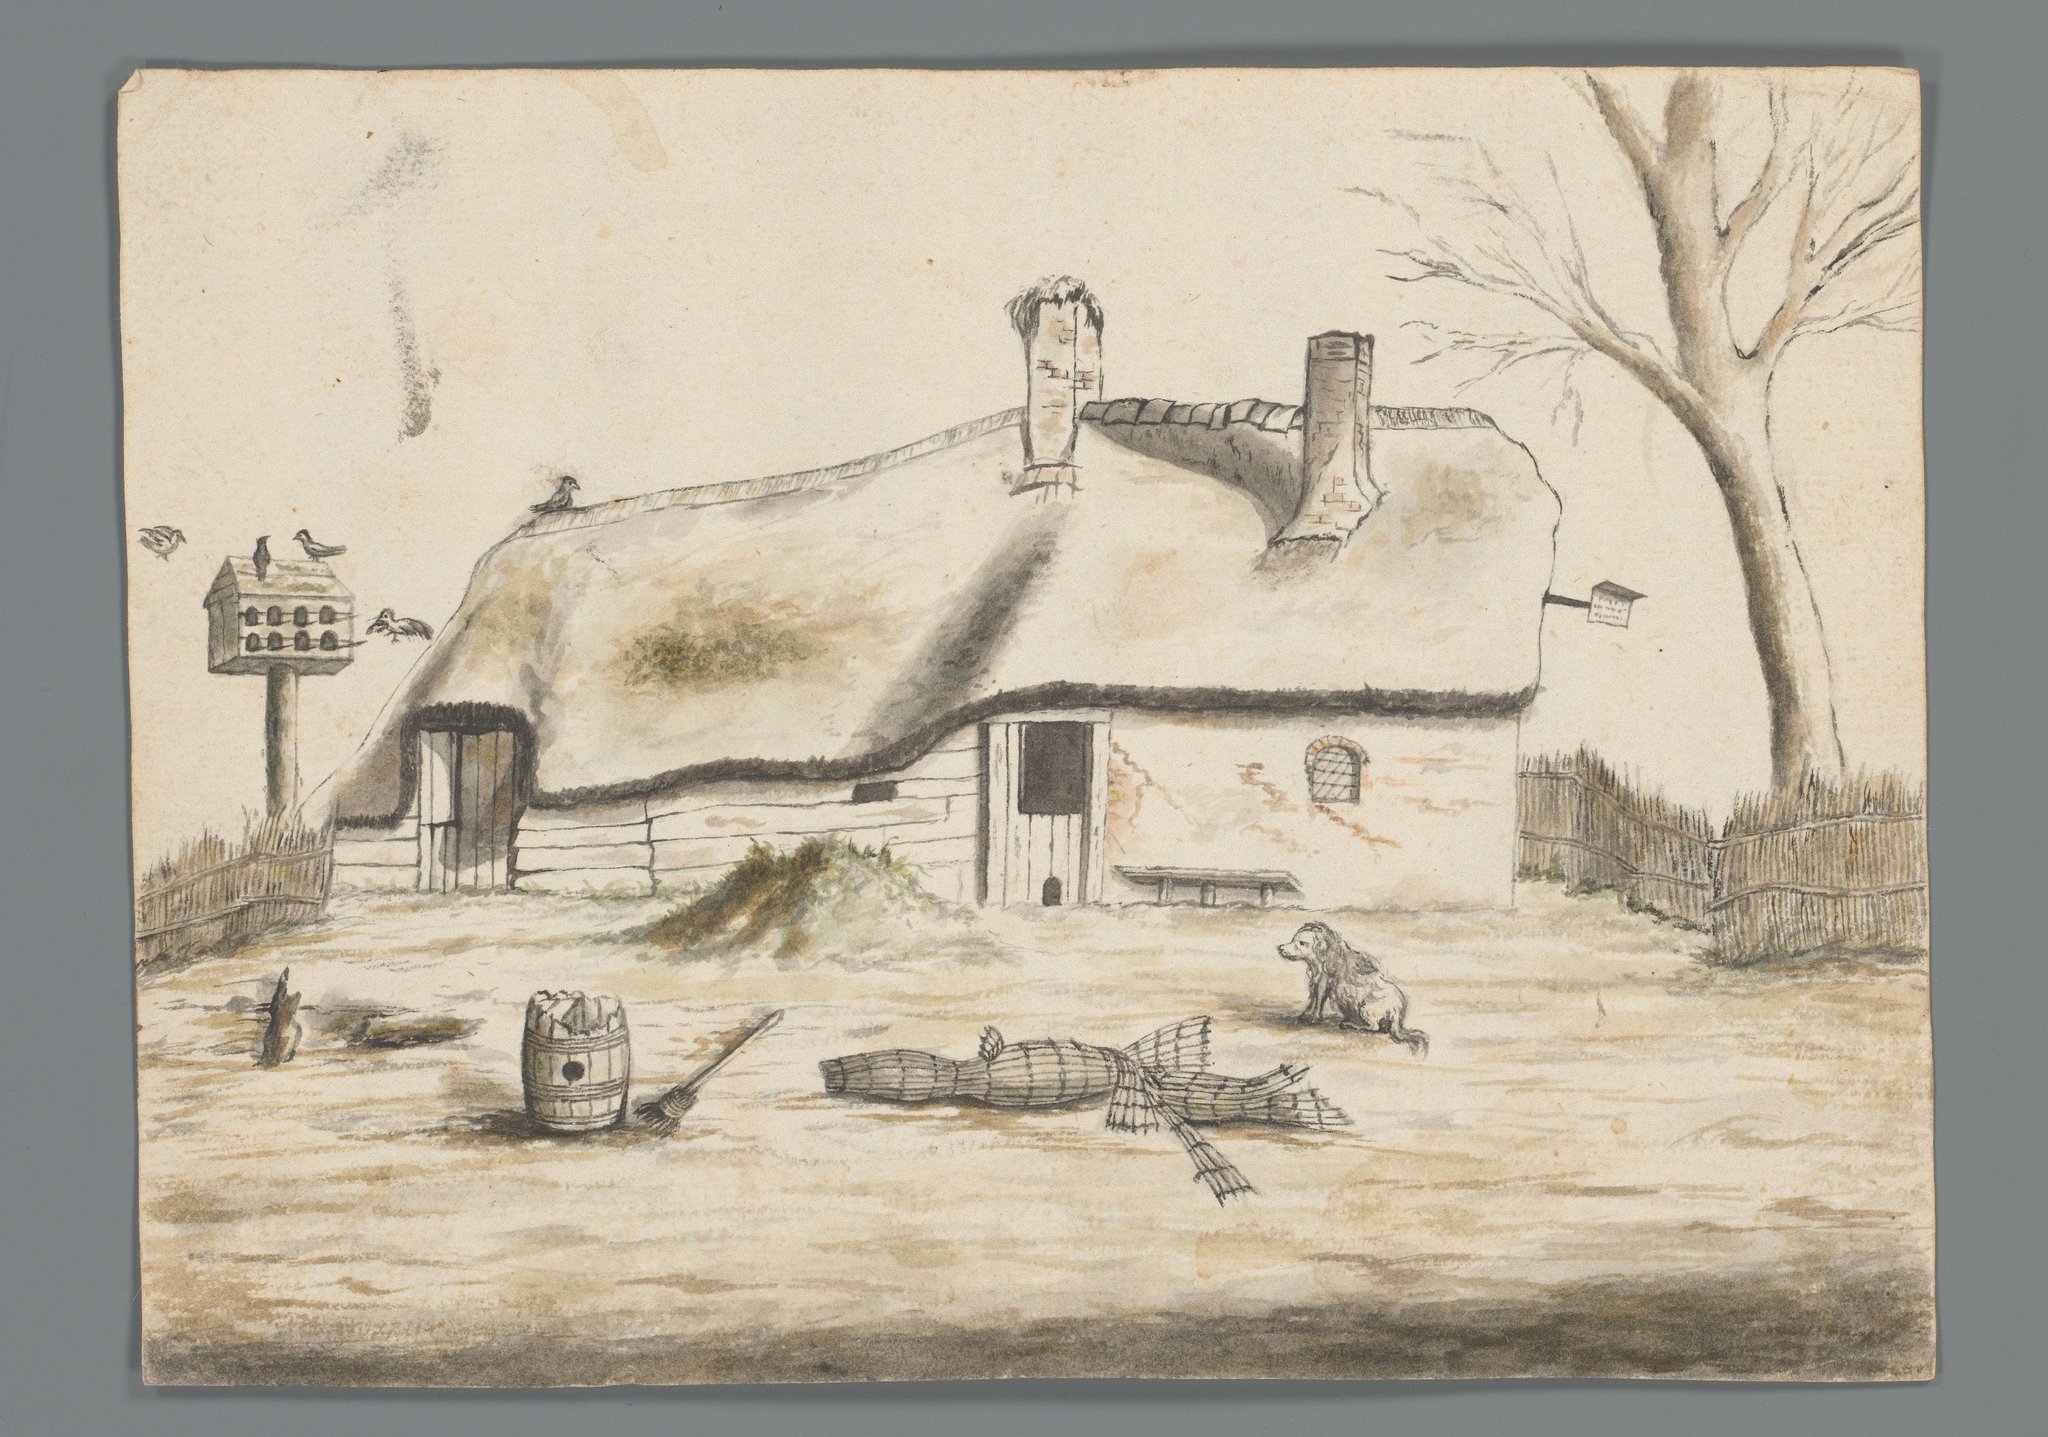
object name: drawing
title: Boerderij met op de voorgrond een ton, fuik en hond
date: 1700-1799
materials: paper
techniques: brush, pen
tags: farm (building), dog